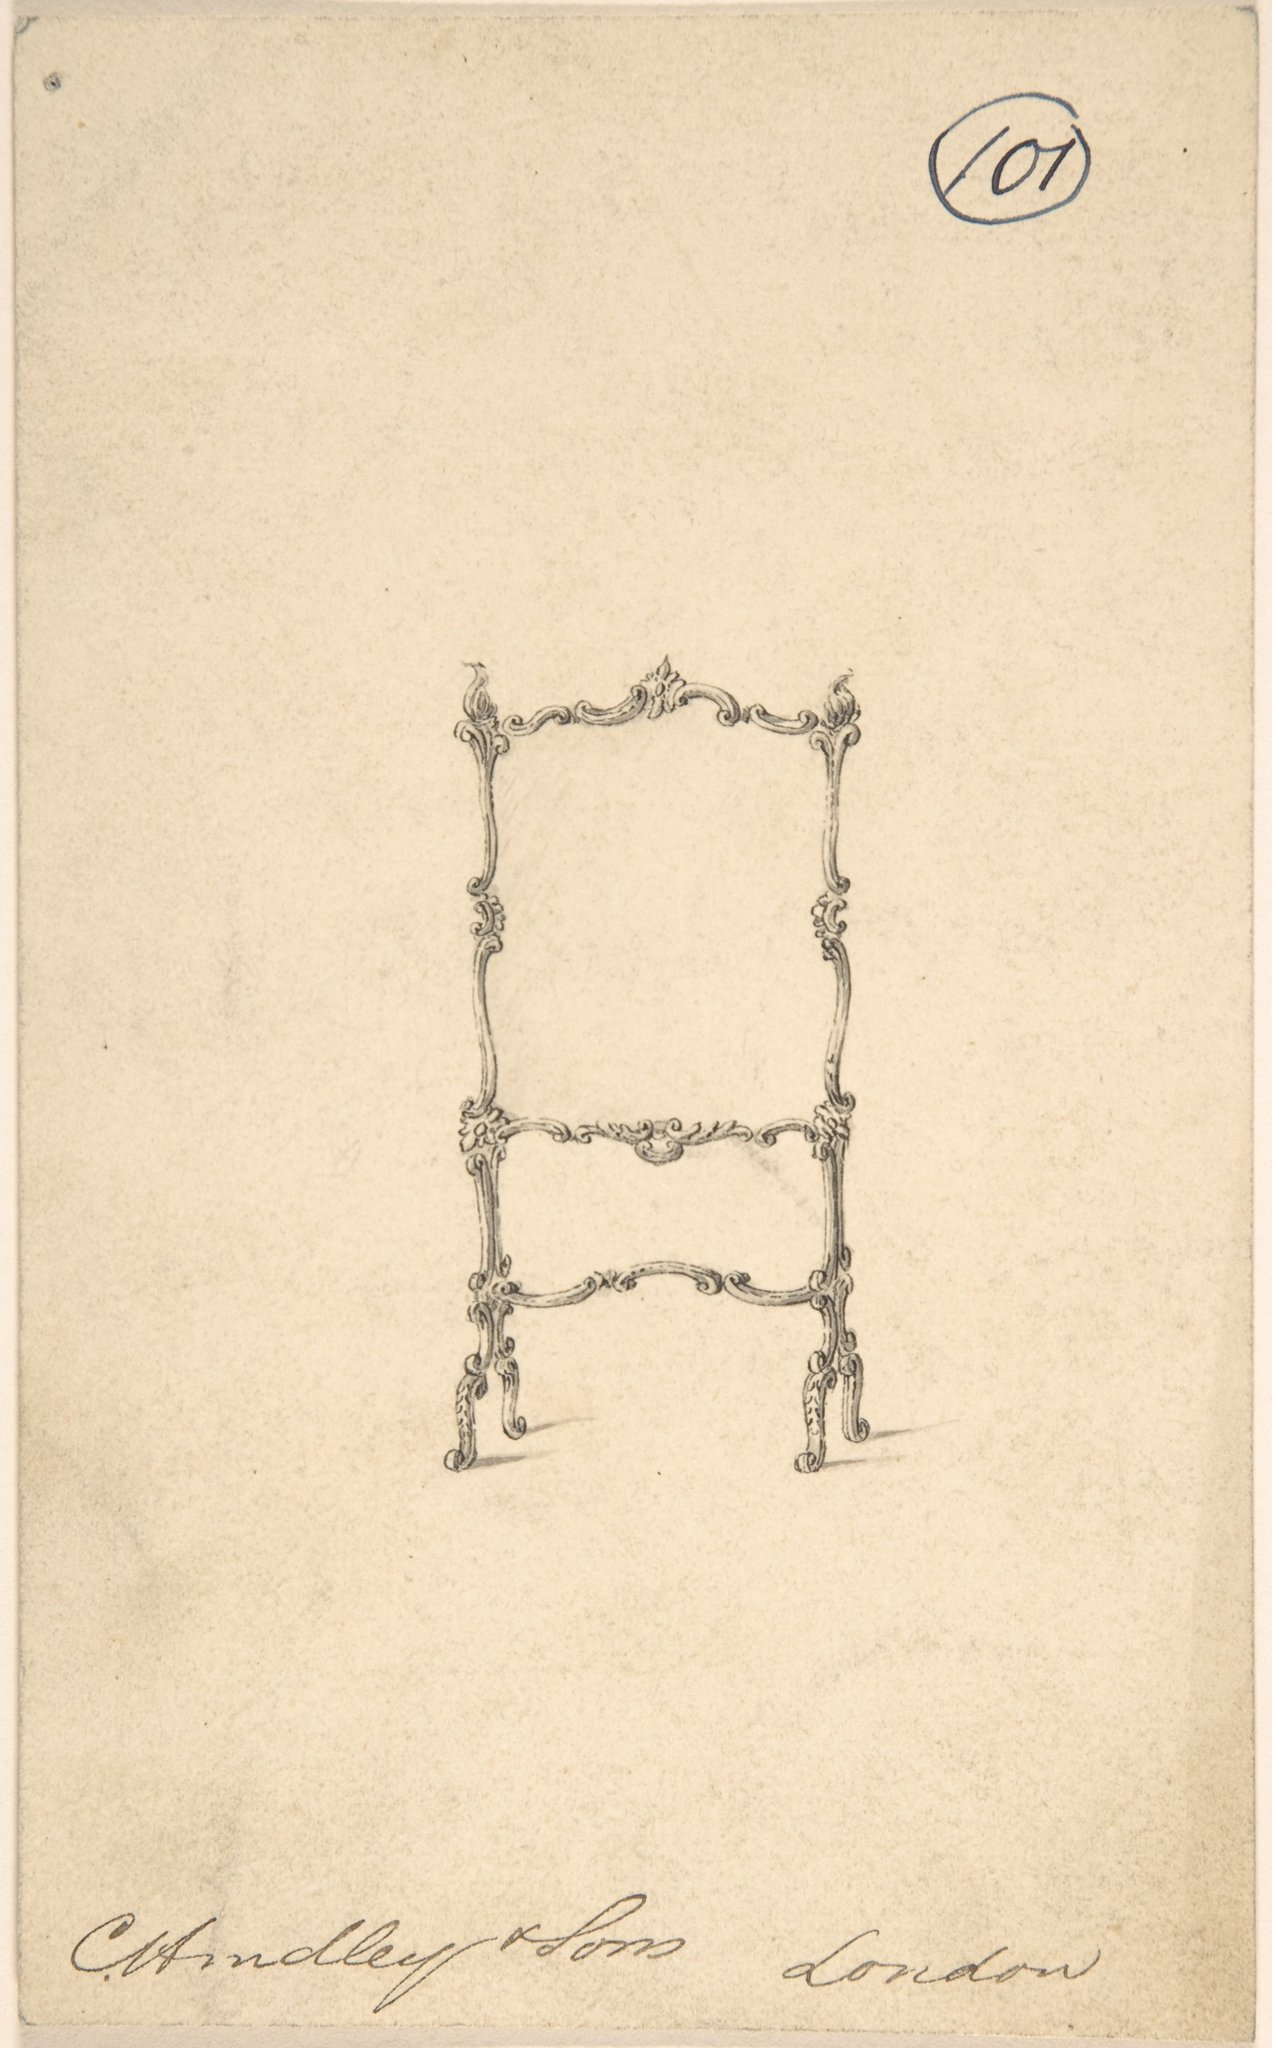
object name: drawing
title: Design for Standing Screen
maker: charles hindley and sons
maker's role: artist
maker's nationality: british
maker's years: 1841-1917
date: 1841-1884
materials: ink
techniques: pen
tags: screens